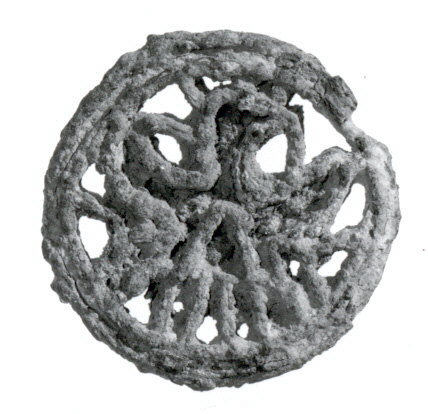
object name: stamp seal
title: Compartmented stamp seal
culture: bactria-margiana archaeological complex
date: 2333-1668 BCE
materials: copper alloy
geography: bactria-margiana